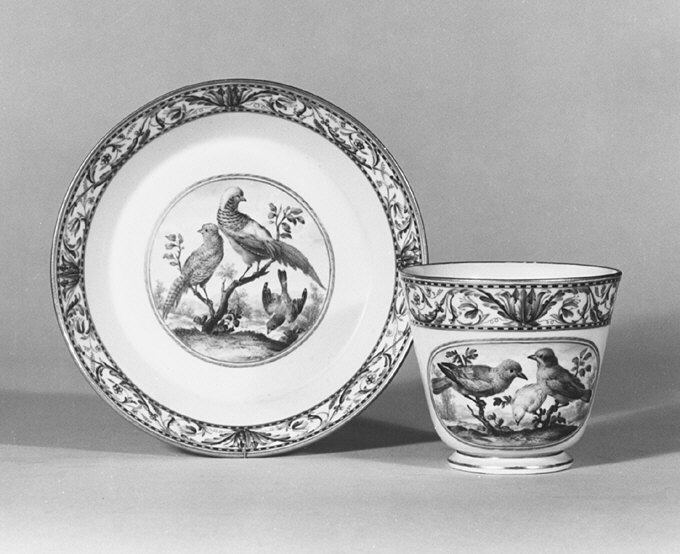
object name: coffee cup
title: Coffee cup (part of a service)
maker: meissen manufactory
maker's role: manufactory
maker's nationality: german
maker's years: 1710-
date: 1780-1785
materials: hard paste porcelain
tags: birds